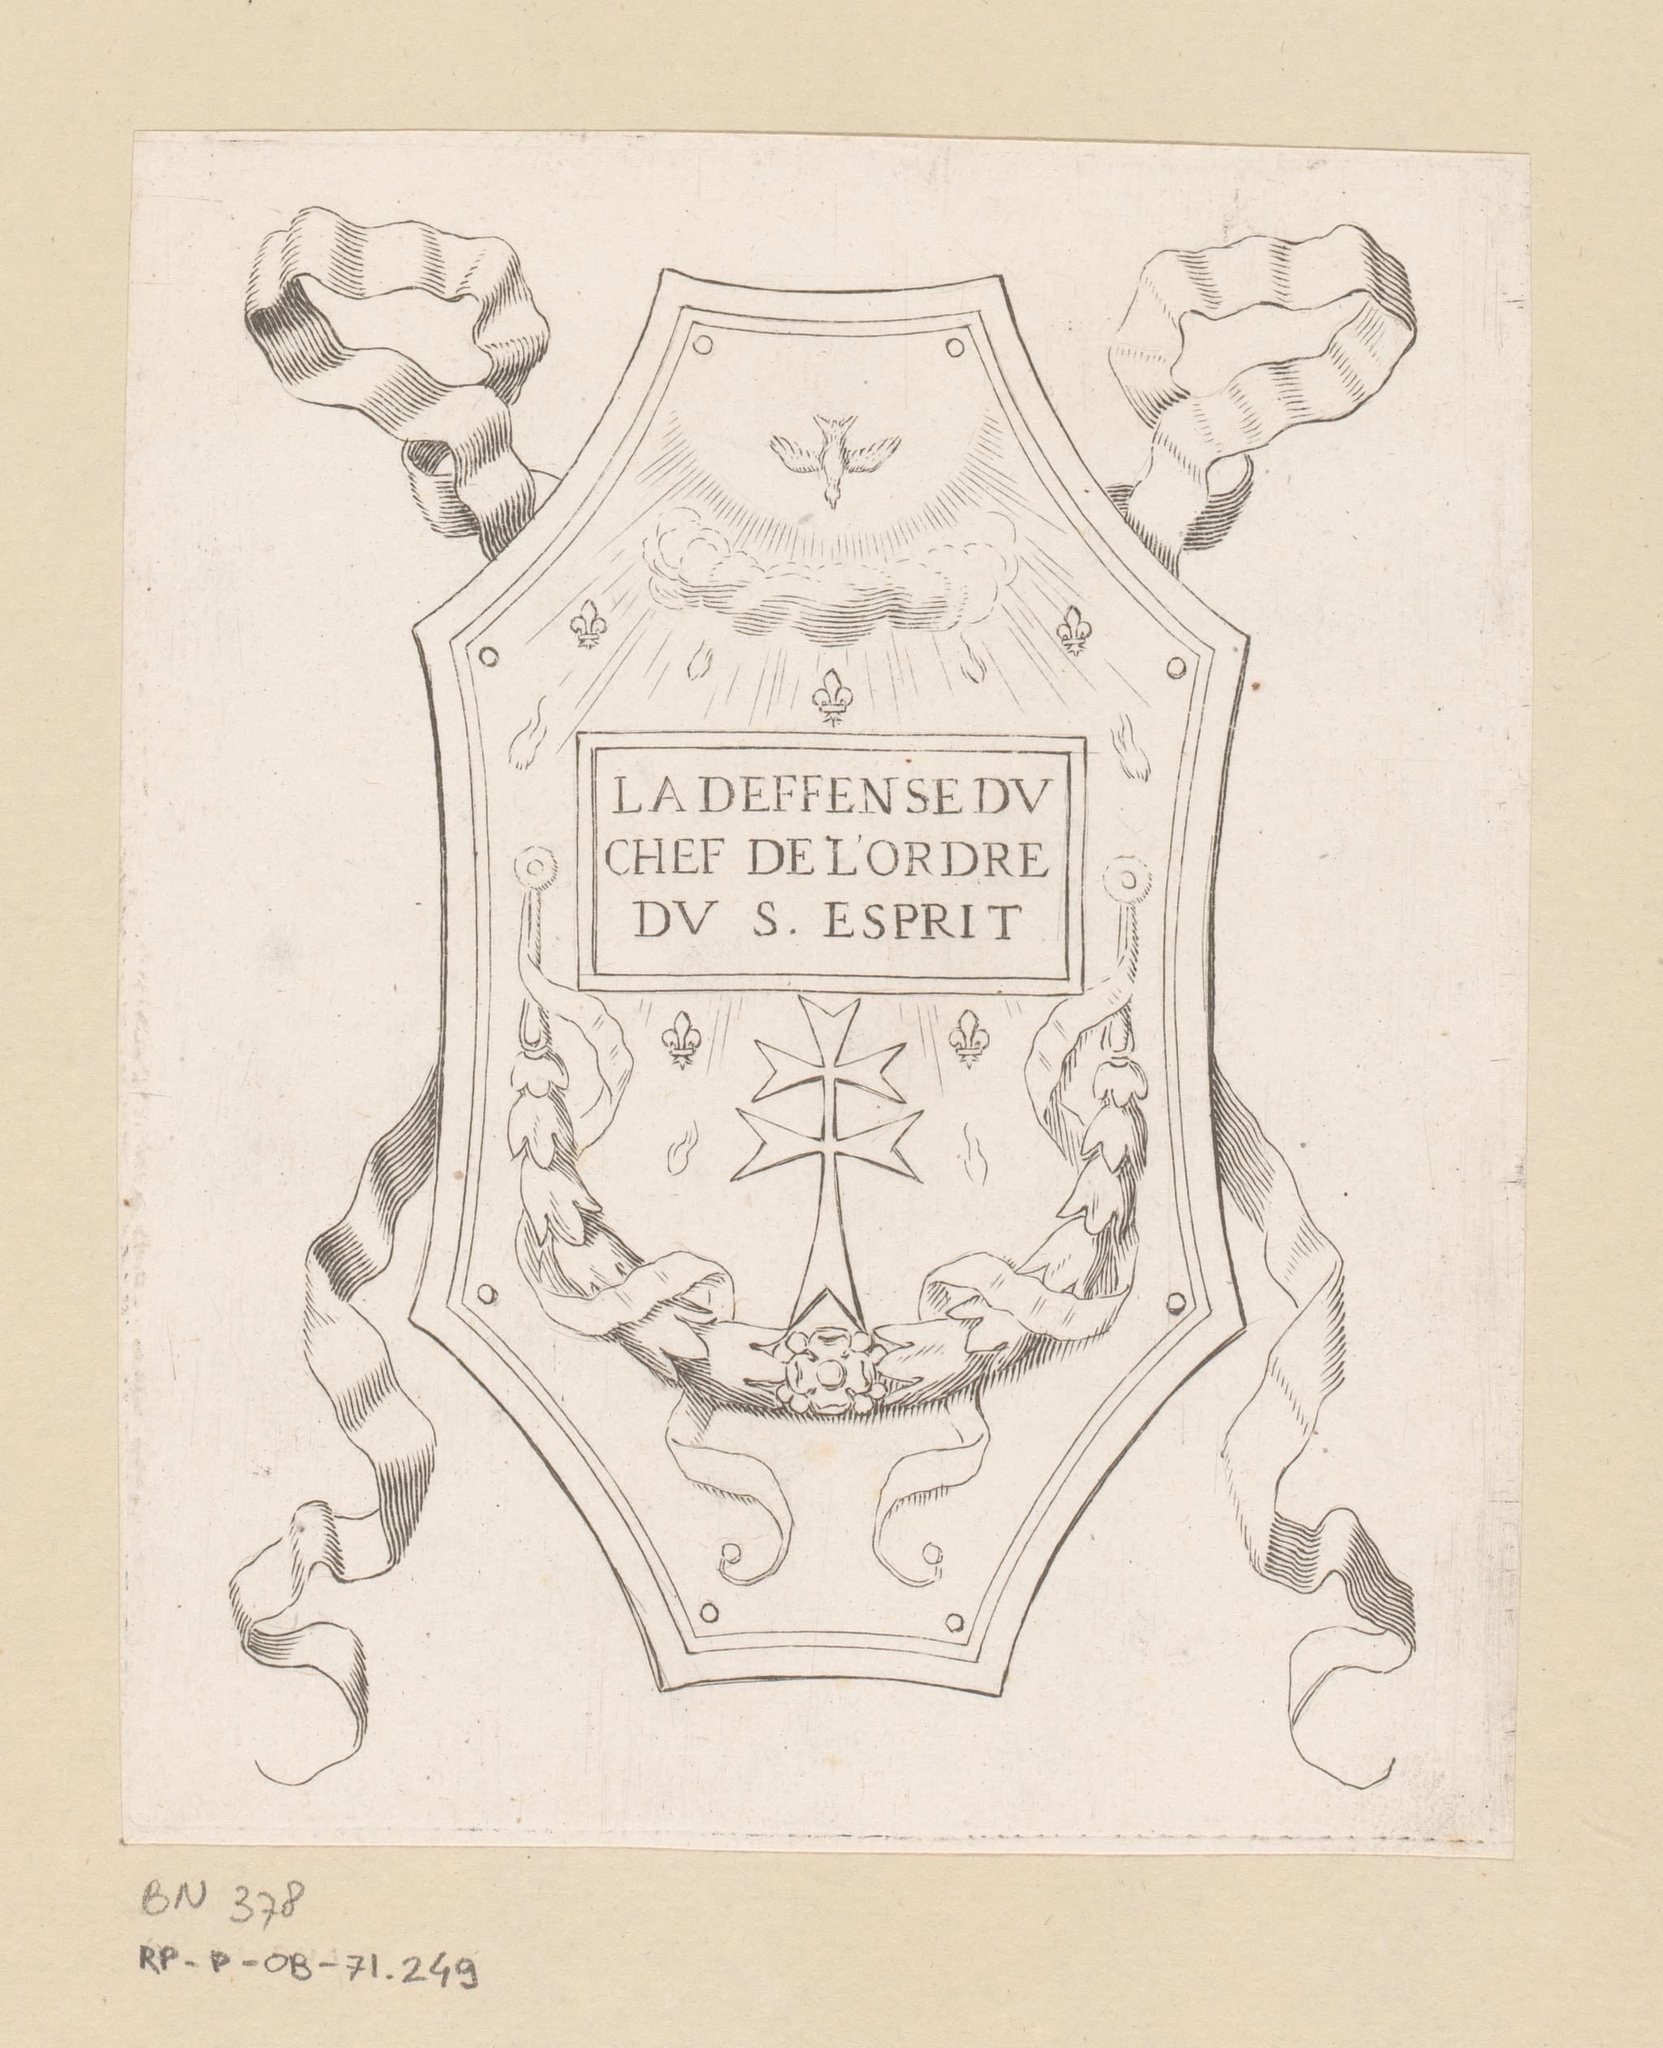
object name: titelblad, titelpagina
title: Titelpagina voor: La Defense du Chef de l'Ordre du S. Esprit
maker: claude mellan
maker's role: draughtsman, print maker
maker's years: 1598-1688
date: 1608-1688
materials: paper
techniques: engraving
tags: protective weapons: shield, knighthood order of the holy spirit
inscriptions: collector's mark: Lugt 240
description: Titelpagina voor een onbekend boek, getiteld 'La Defense du Chef de l'Ordre du S. Esprit', waarschijnlijk uitgegeven door de Imprimerie Royale.